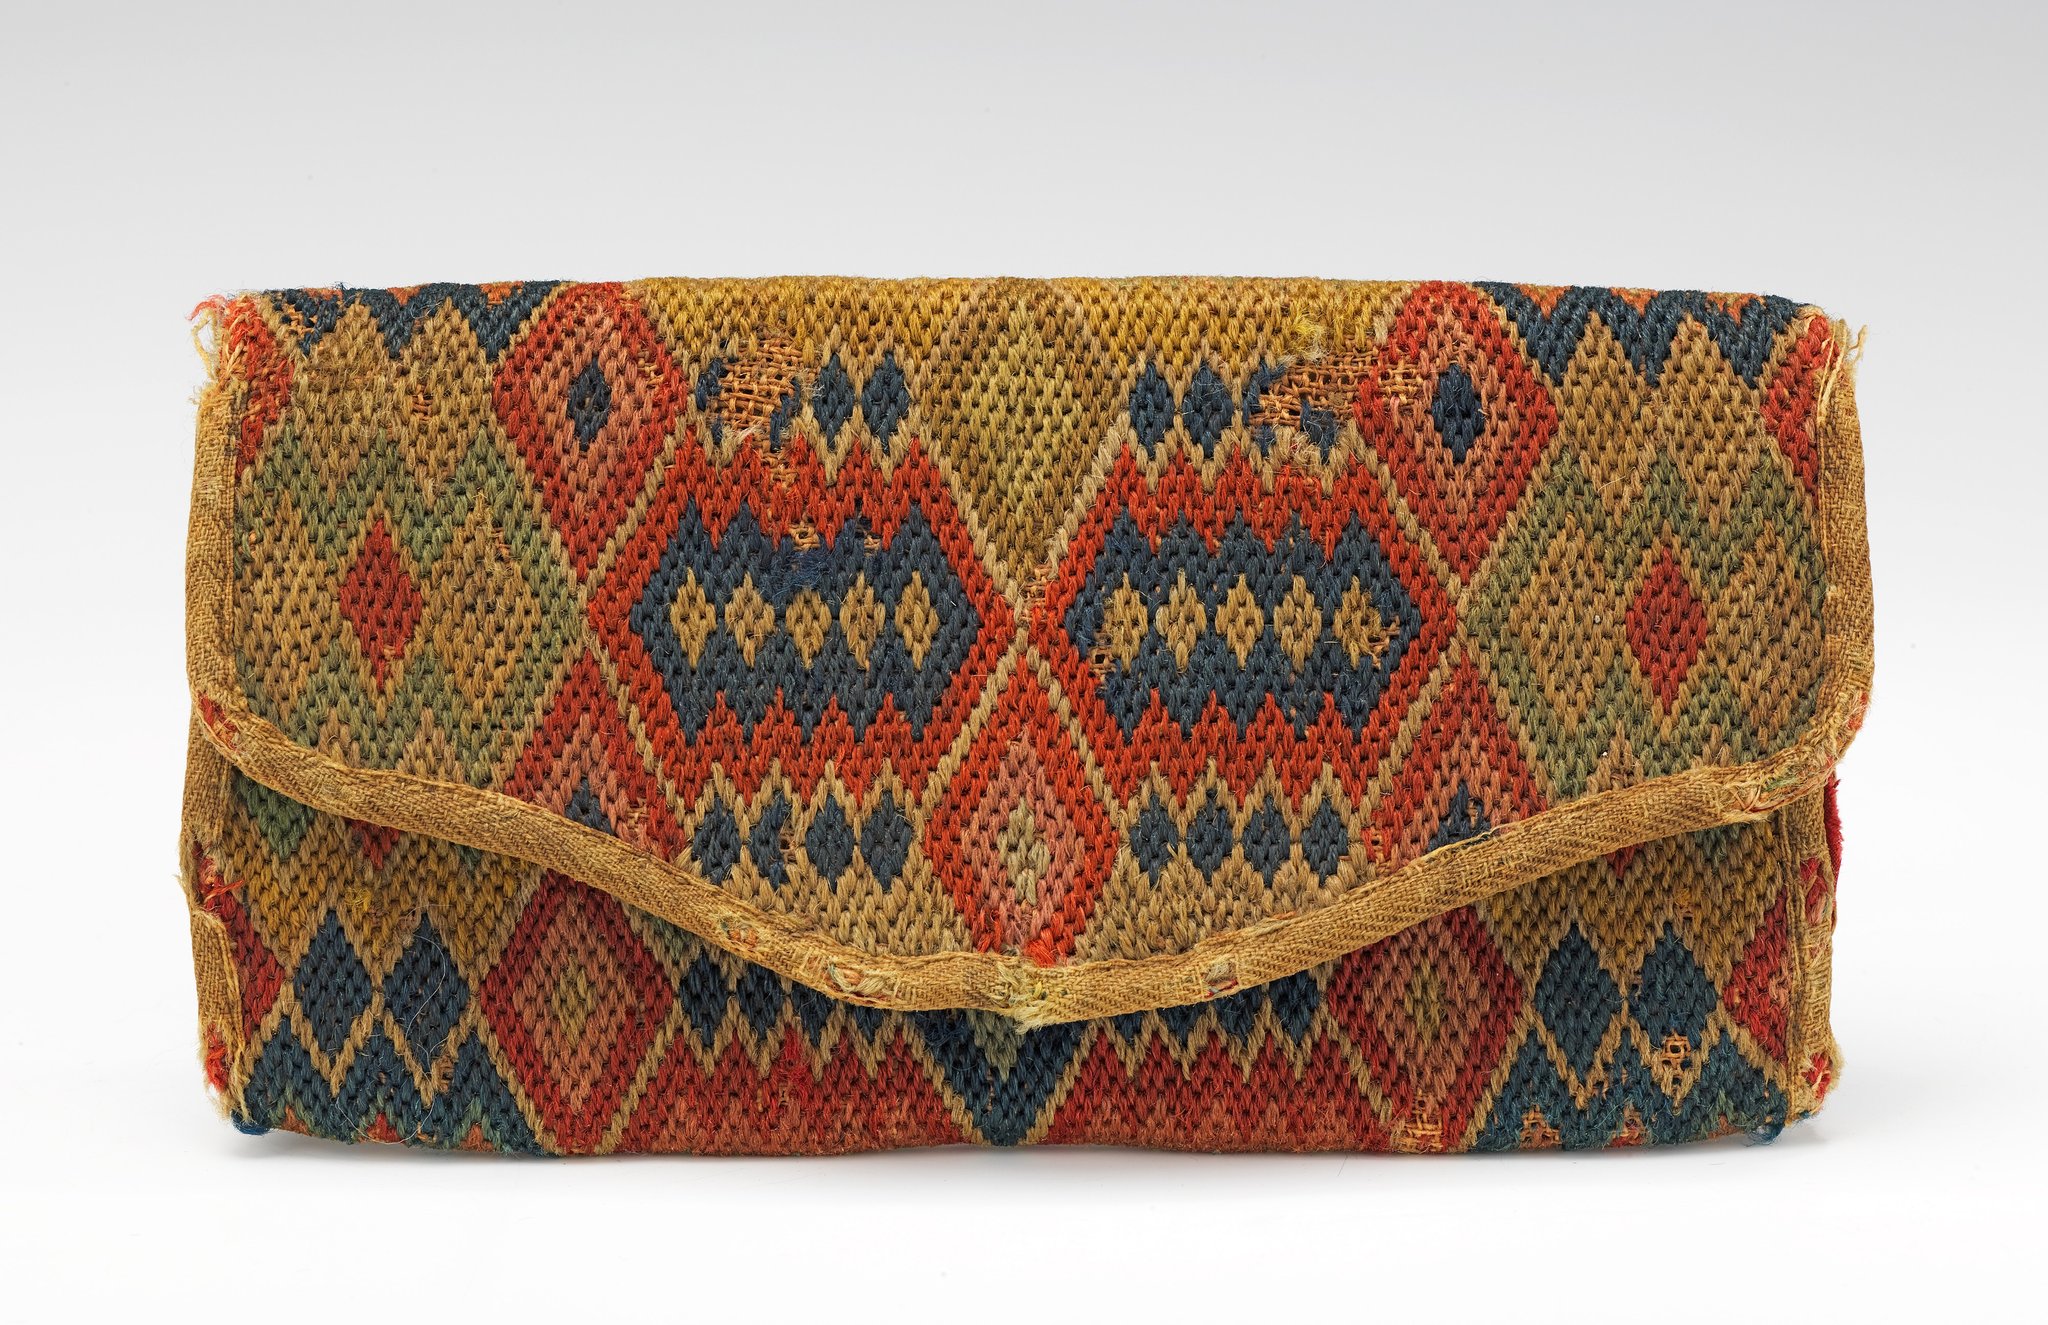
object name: purse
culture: american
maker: deborah hill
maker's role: designer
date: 1776-1800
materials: linen, silk, wool